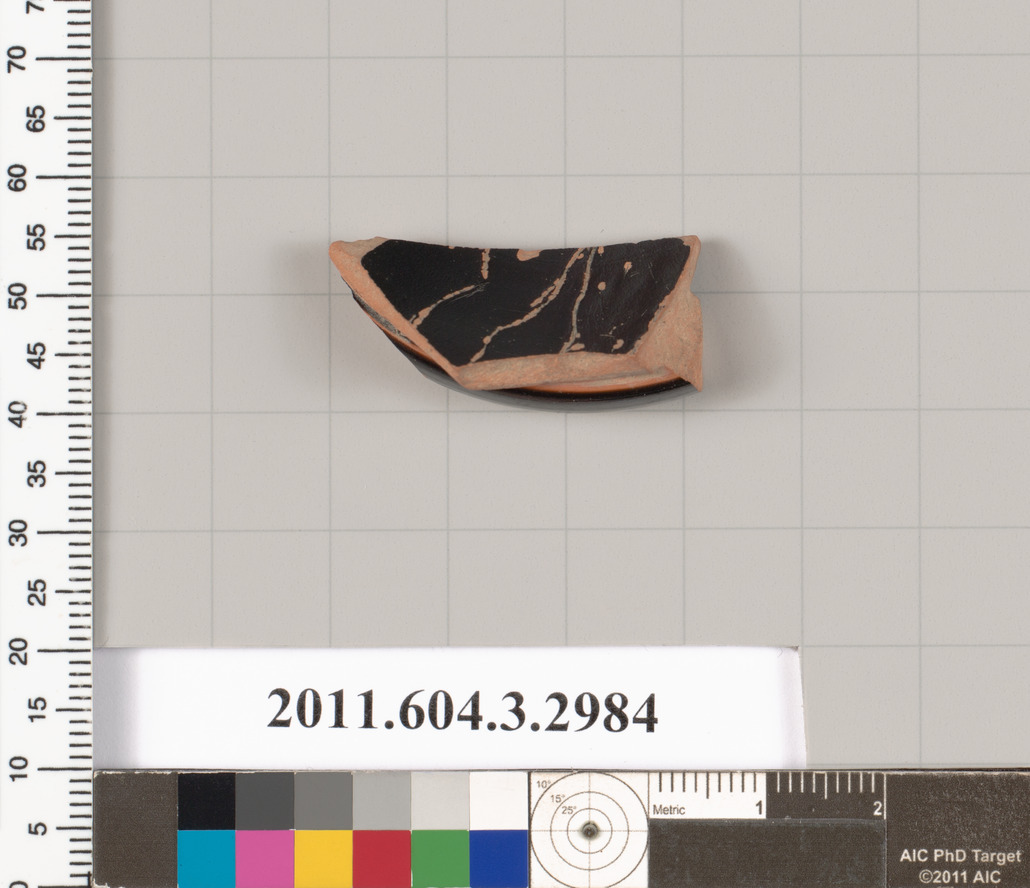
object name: kylix fragment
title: Terracotta fragment of a stemless kylix (drinking cup)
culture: greek, attic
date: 500-490 BCE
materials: terracotta